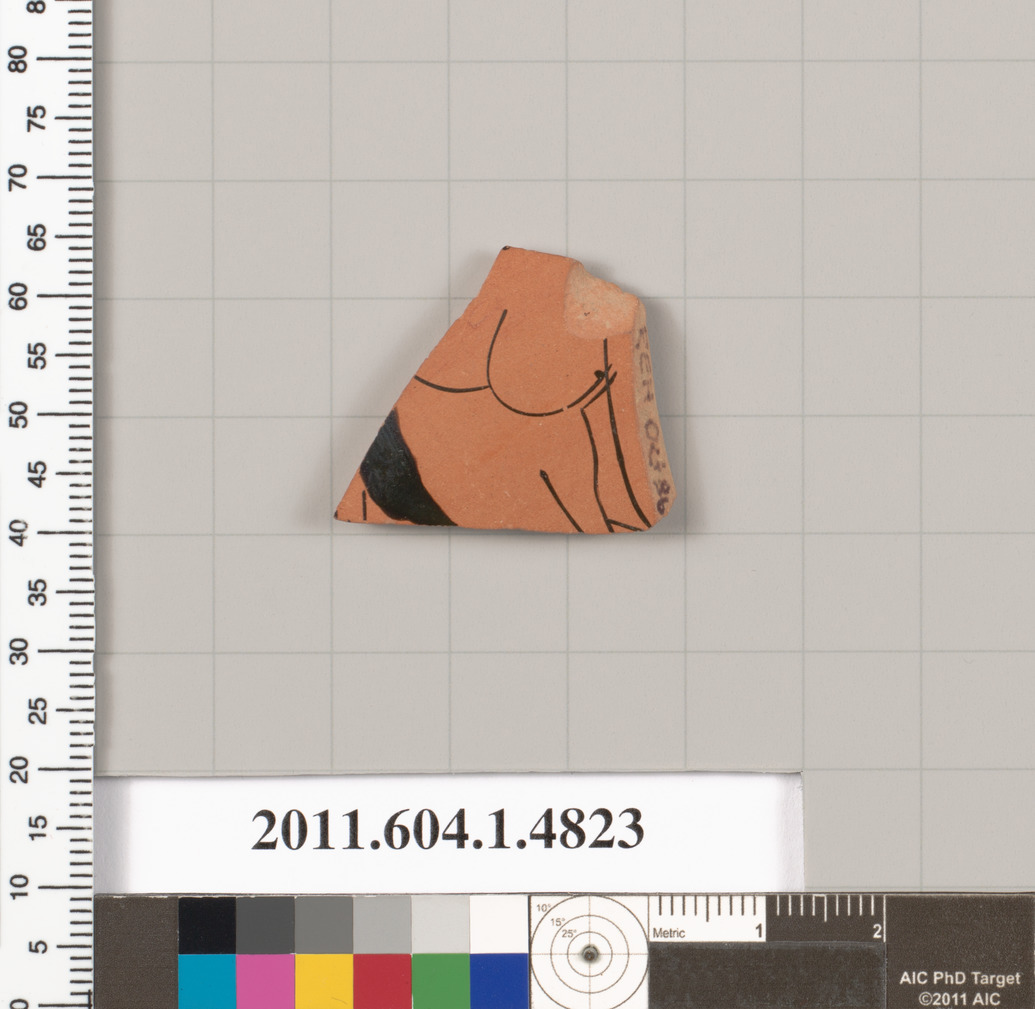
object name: kylix fragment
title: Terracotta fragment of a kylix (drinking cup)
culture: greek, attic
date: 490-480 BCE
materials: terracotta